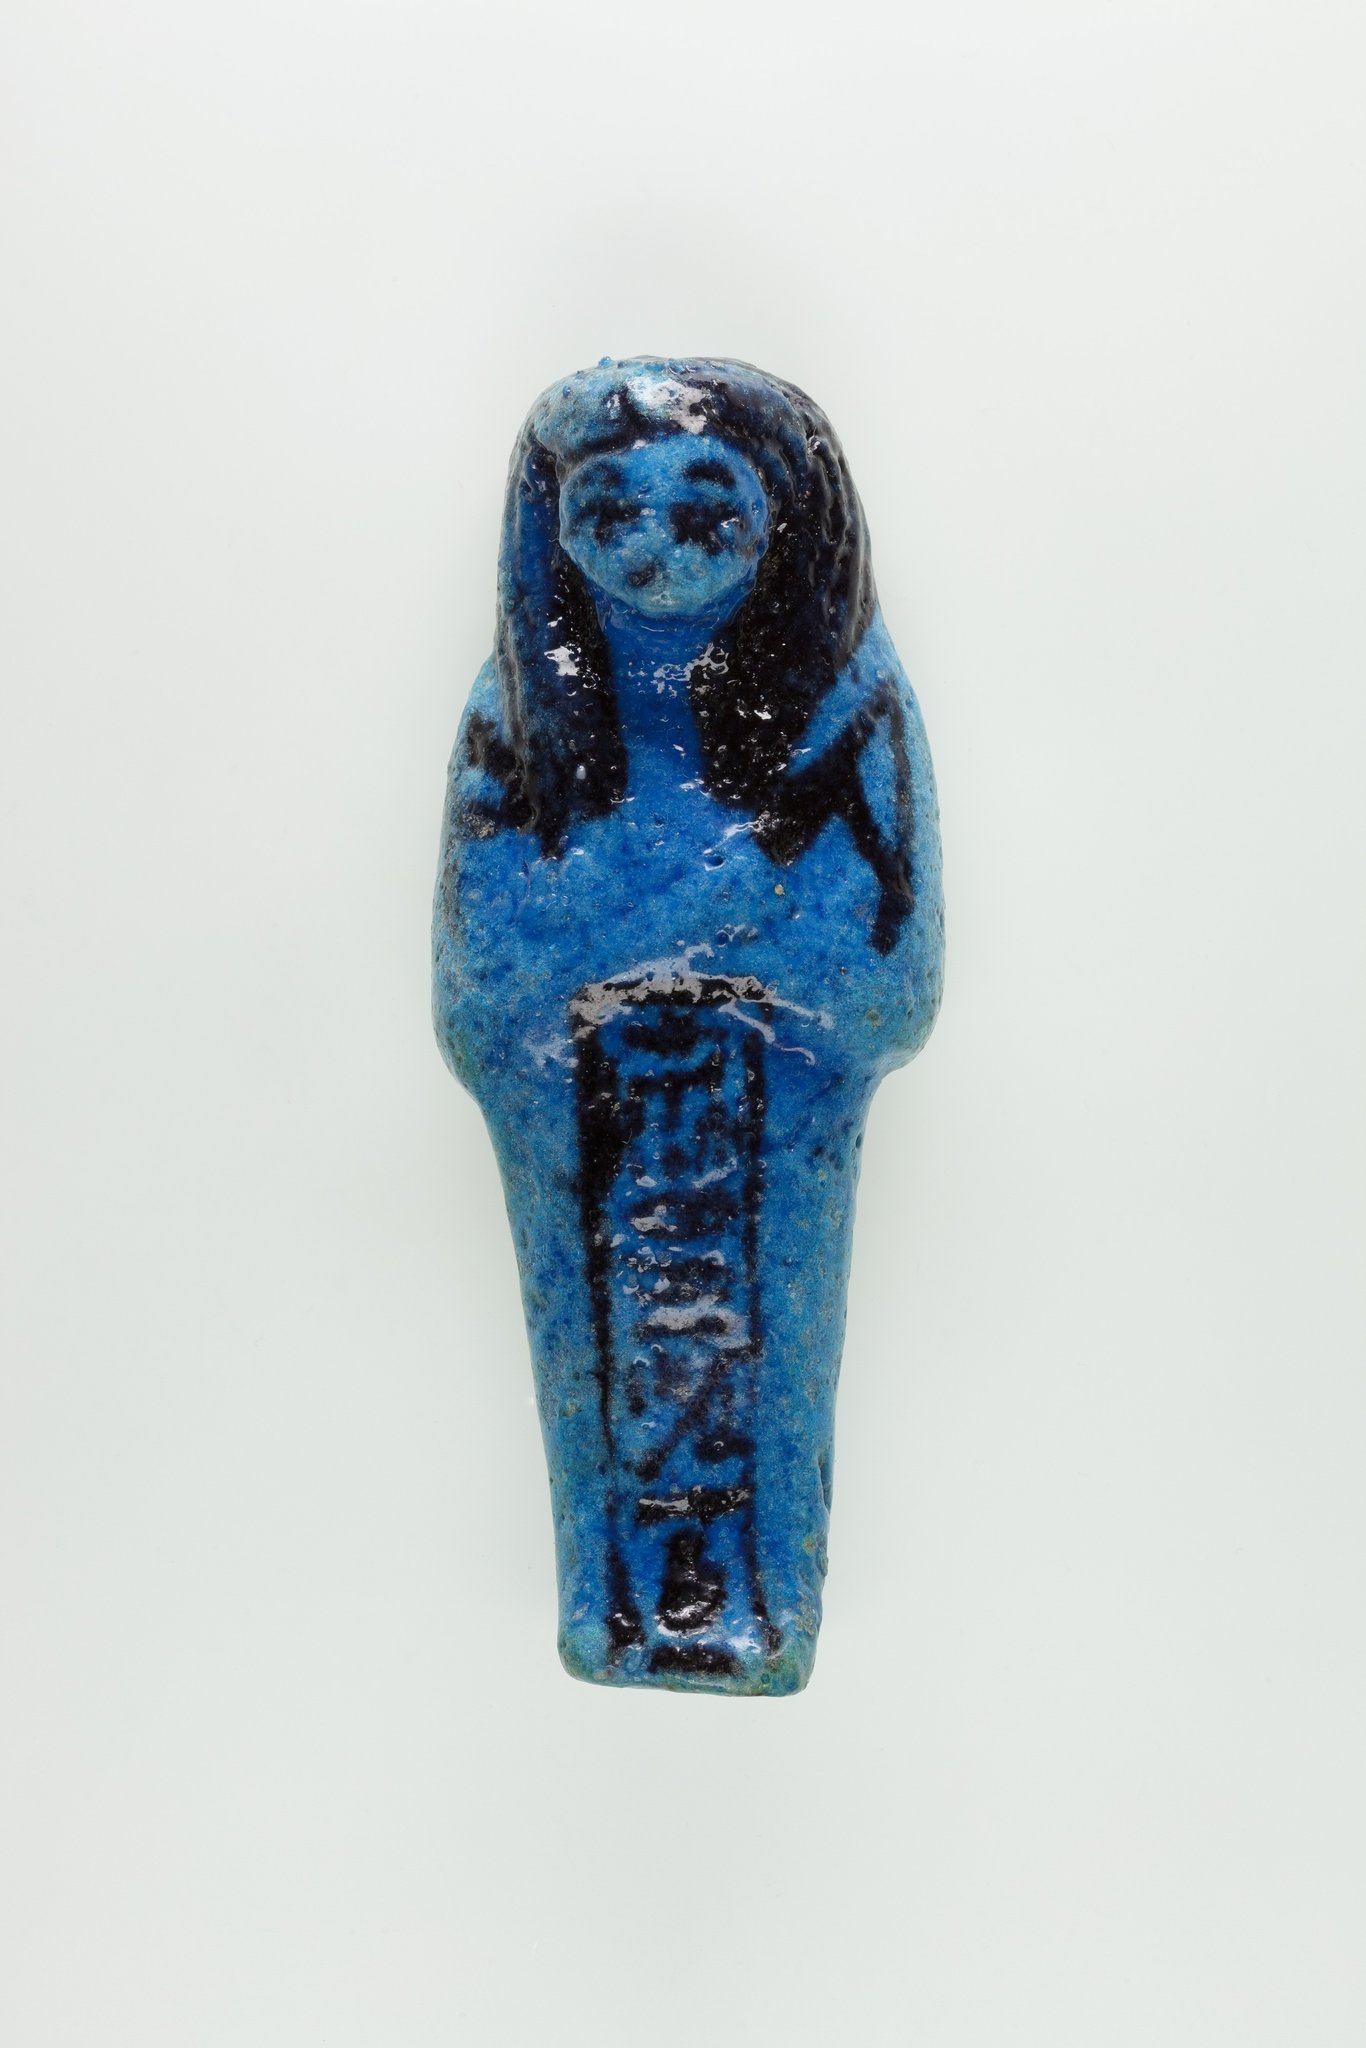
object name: shabti, worker, nauny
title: Worker Shabti of Nauny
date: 1050 BCE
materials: faience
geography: egypt